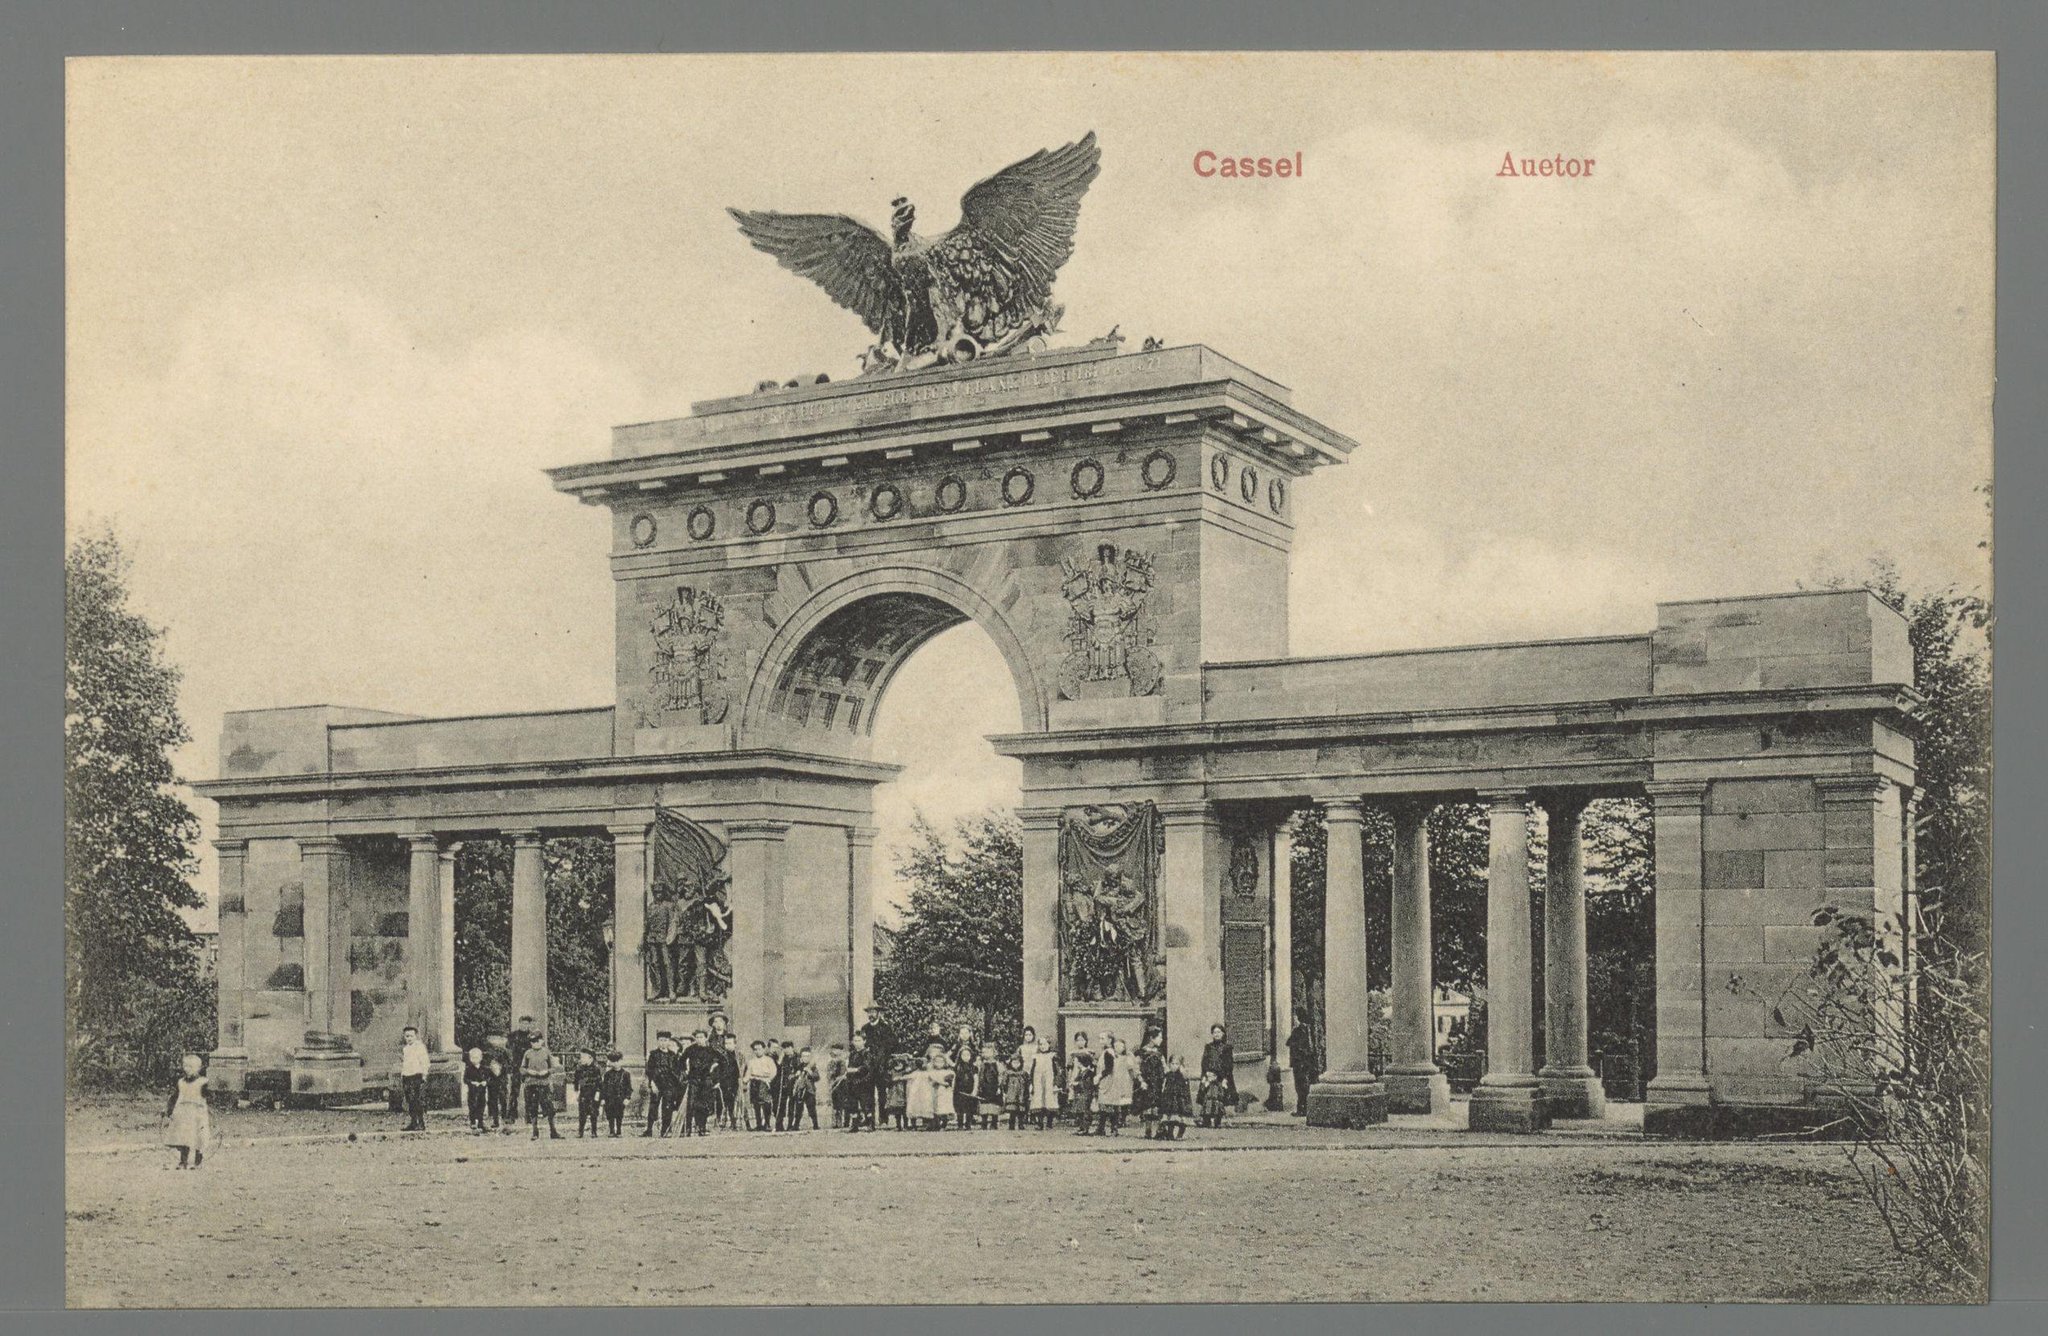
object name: ansichtkaart, prentbriefkaart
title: Cassel. Auetor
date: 1907-1930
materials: cardboard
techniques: photograph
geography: kassel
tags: arch, archivolt ~ architecture, monument, statue